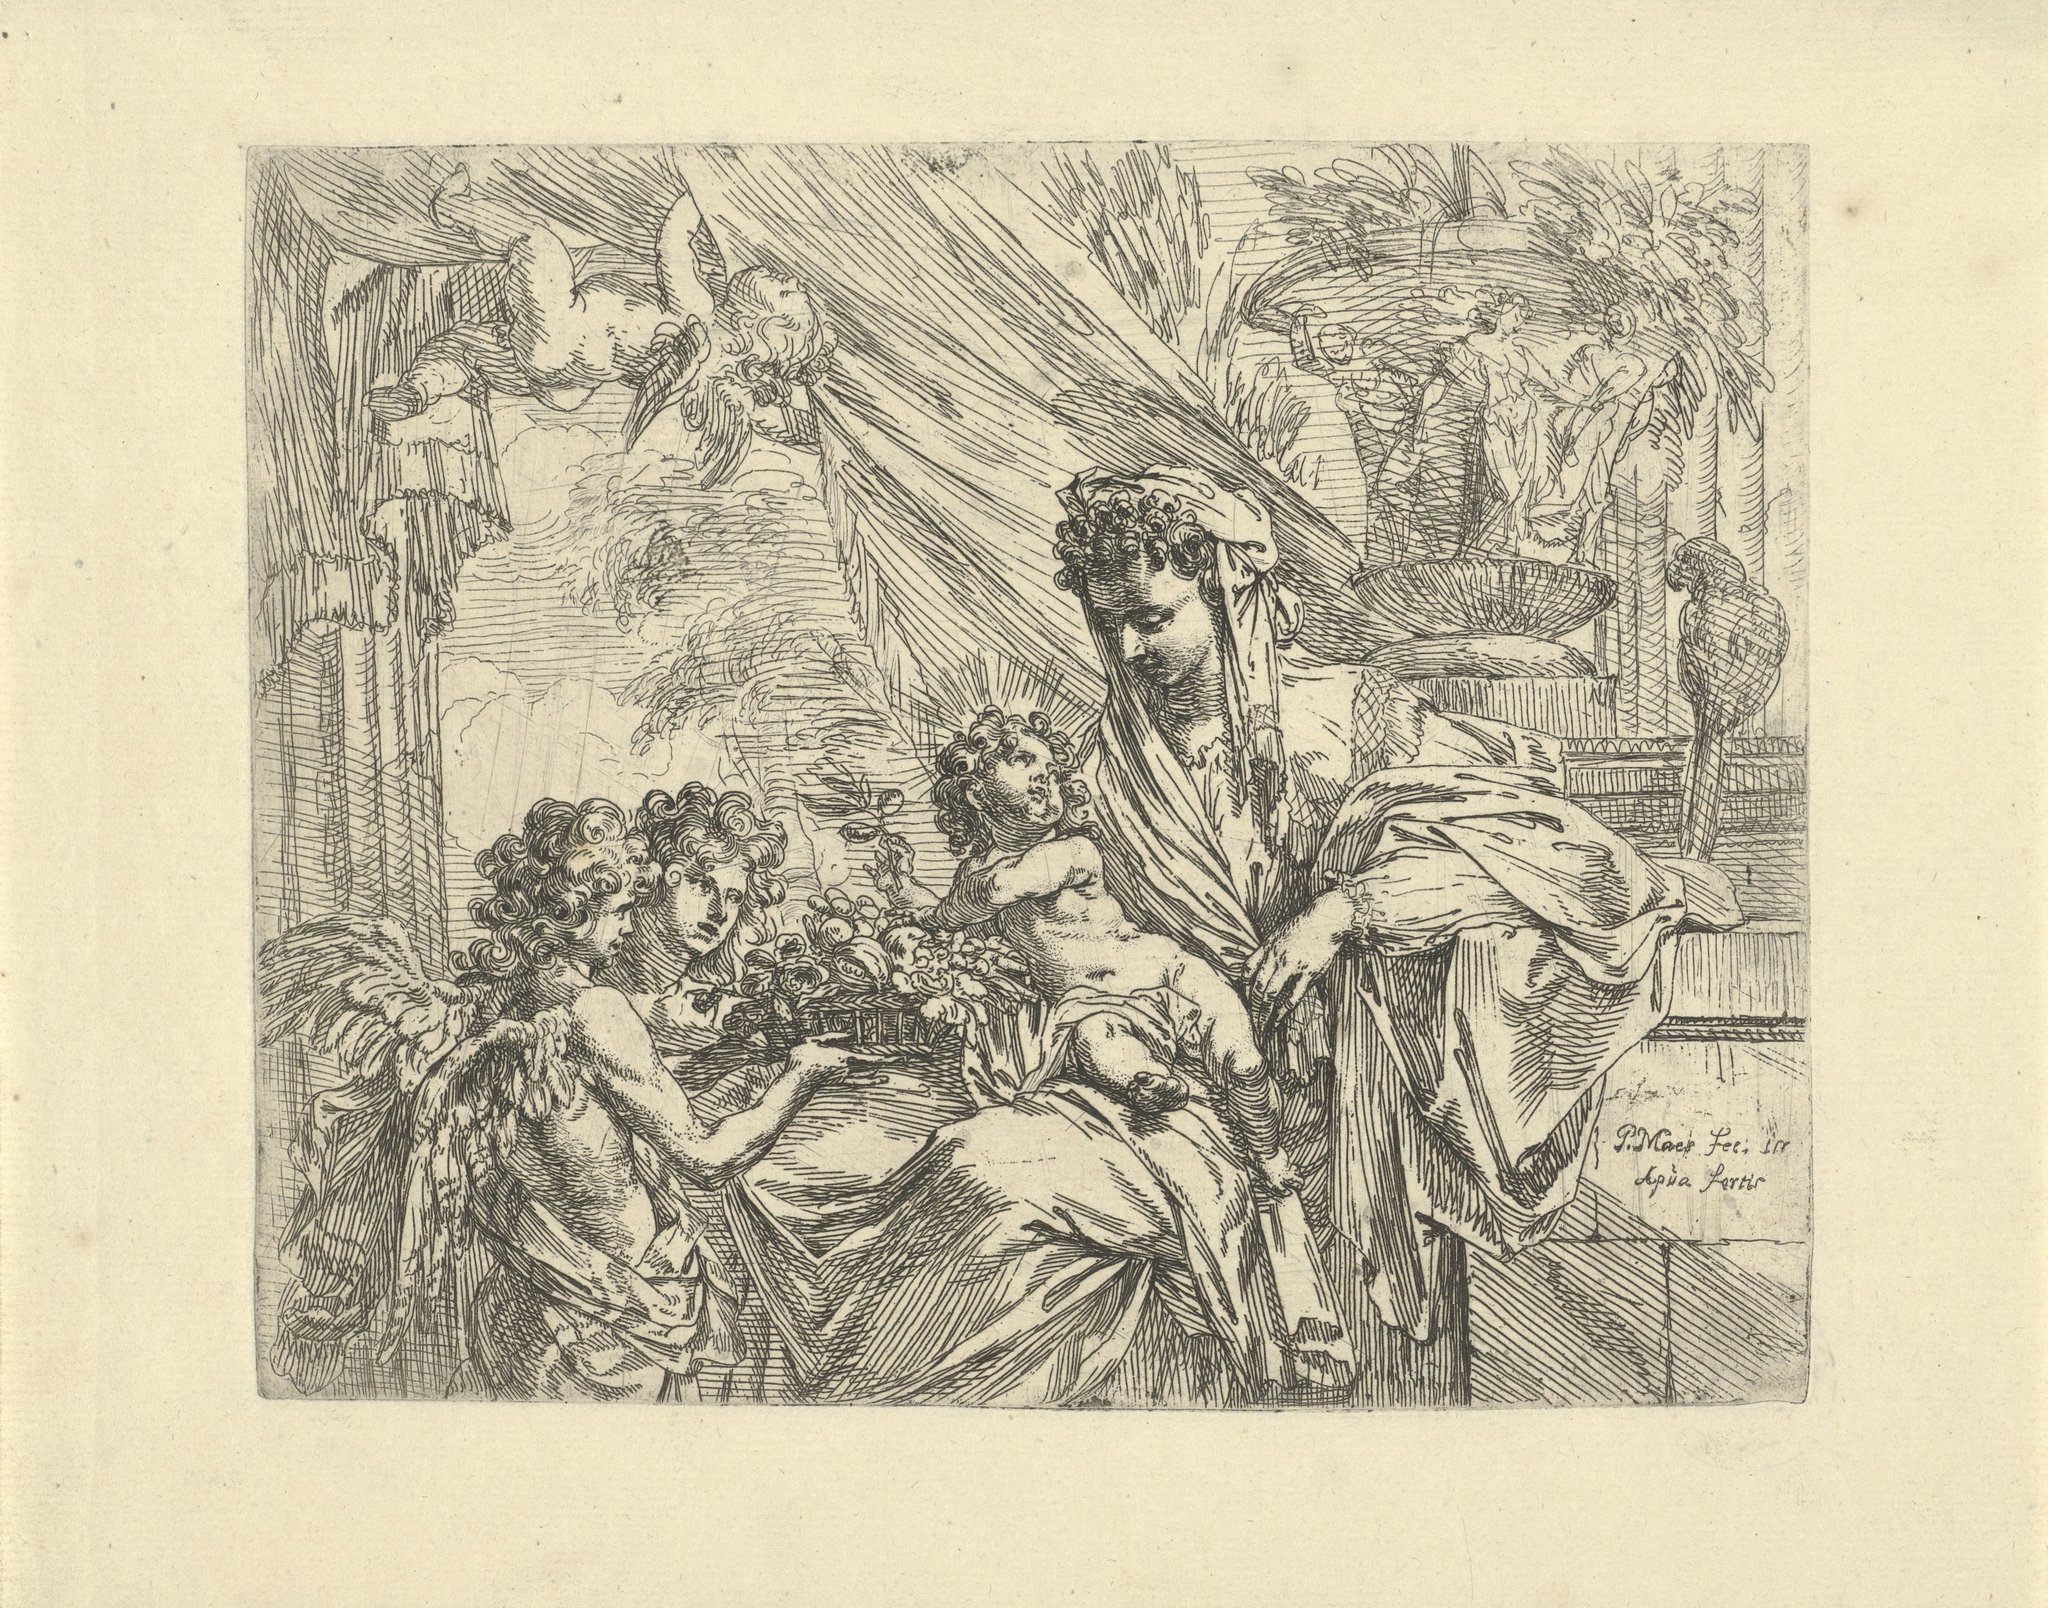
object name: print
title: Maria met Kind aanbeden door engelen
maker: godfried maes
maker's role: draughtsman, painter, print maker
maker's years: 1649-1700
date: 1659-1700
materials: paper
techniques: etching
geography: antwerp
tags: ornamental birds: parrot, madonna: i.e. mary with the christ-child (+ angel(s)), garden vase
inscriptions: collector's mark: Lugt 240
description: Maria en het Christuskind, zittend bij een tuinvaas, krijgen een mand met bloemen en vruchten aangeboden door twee engelen. Linksboven houdt een putto een gordijn op. Rechts een papegaai.